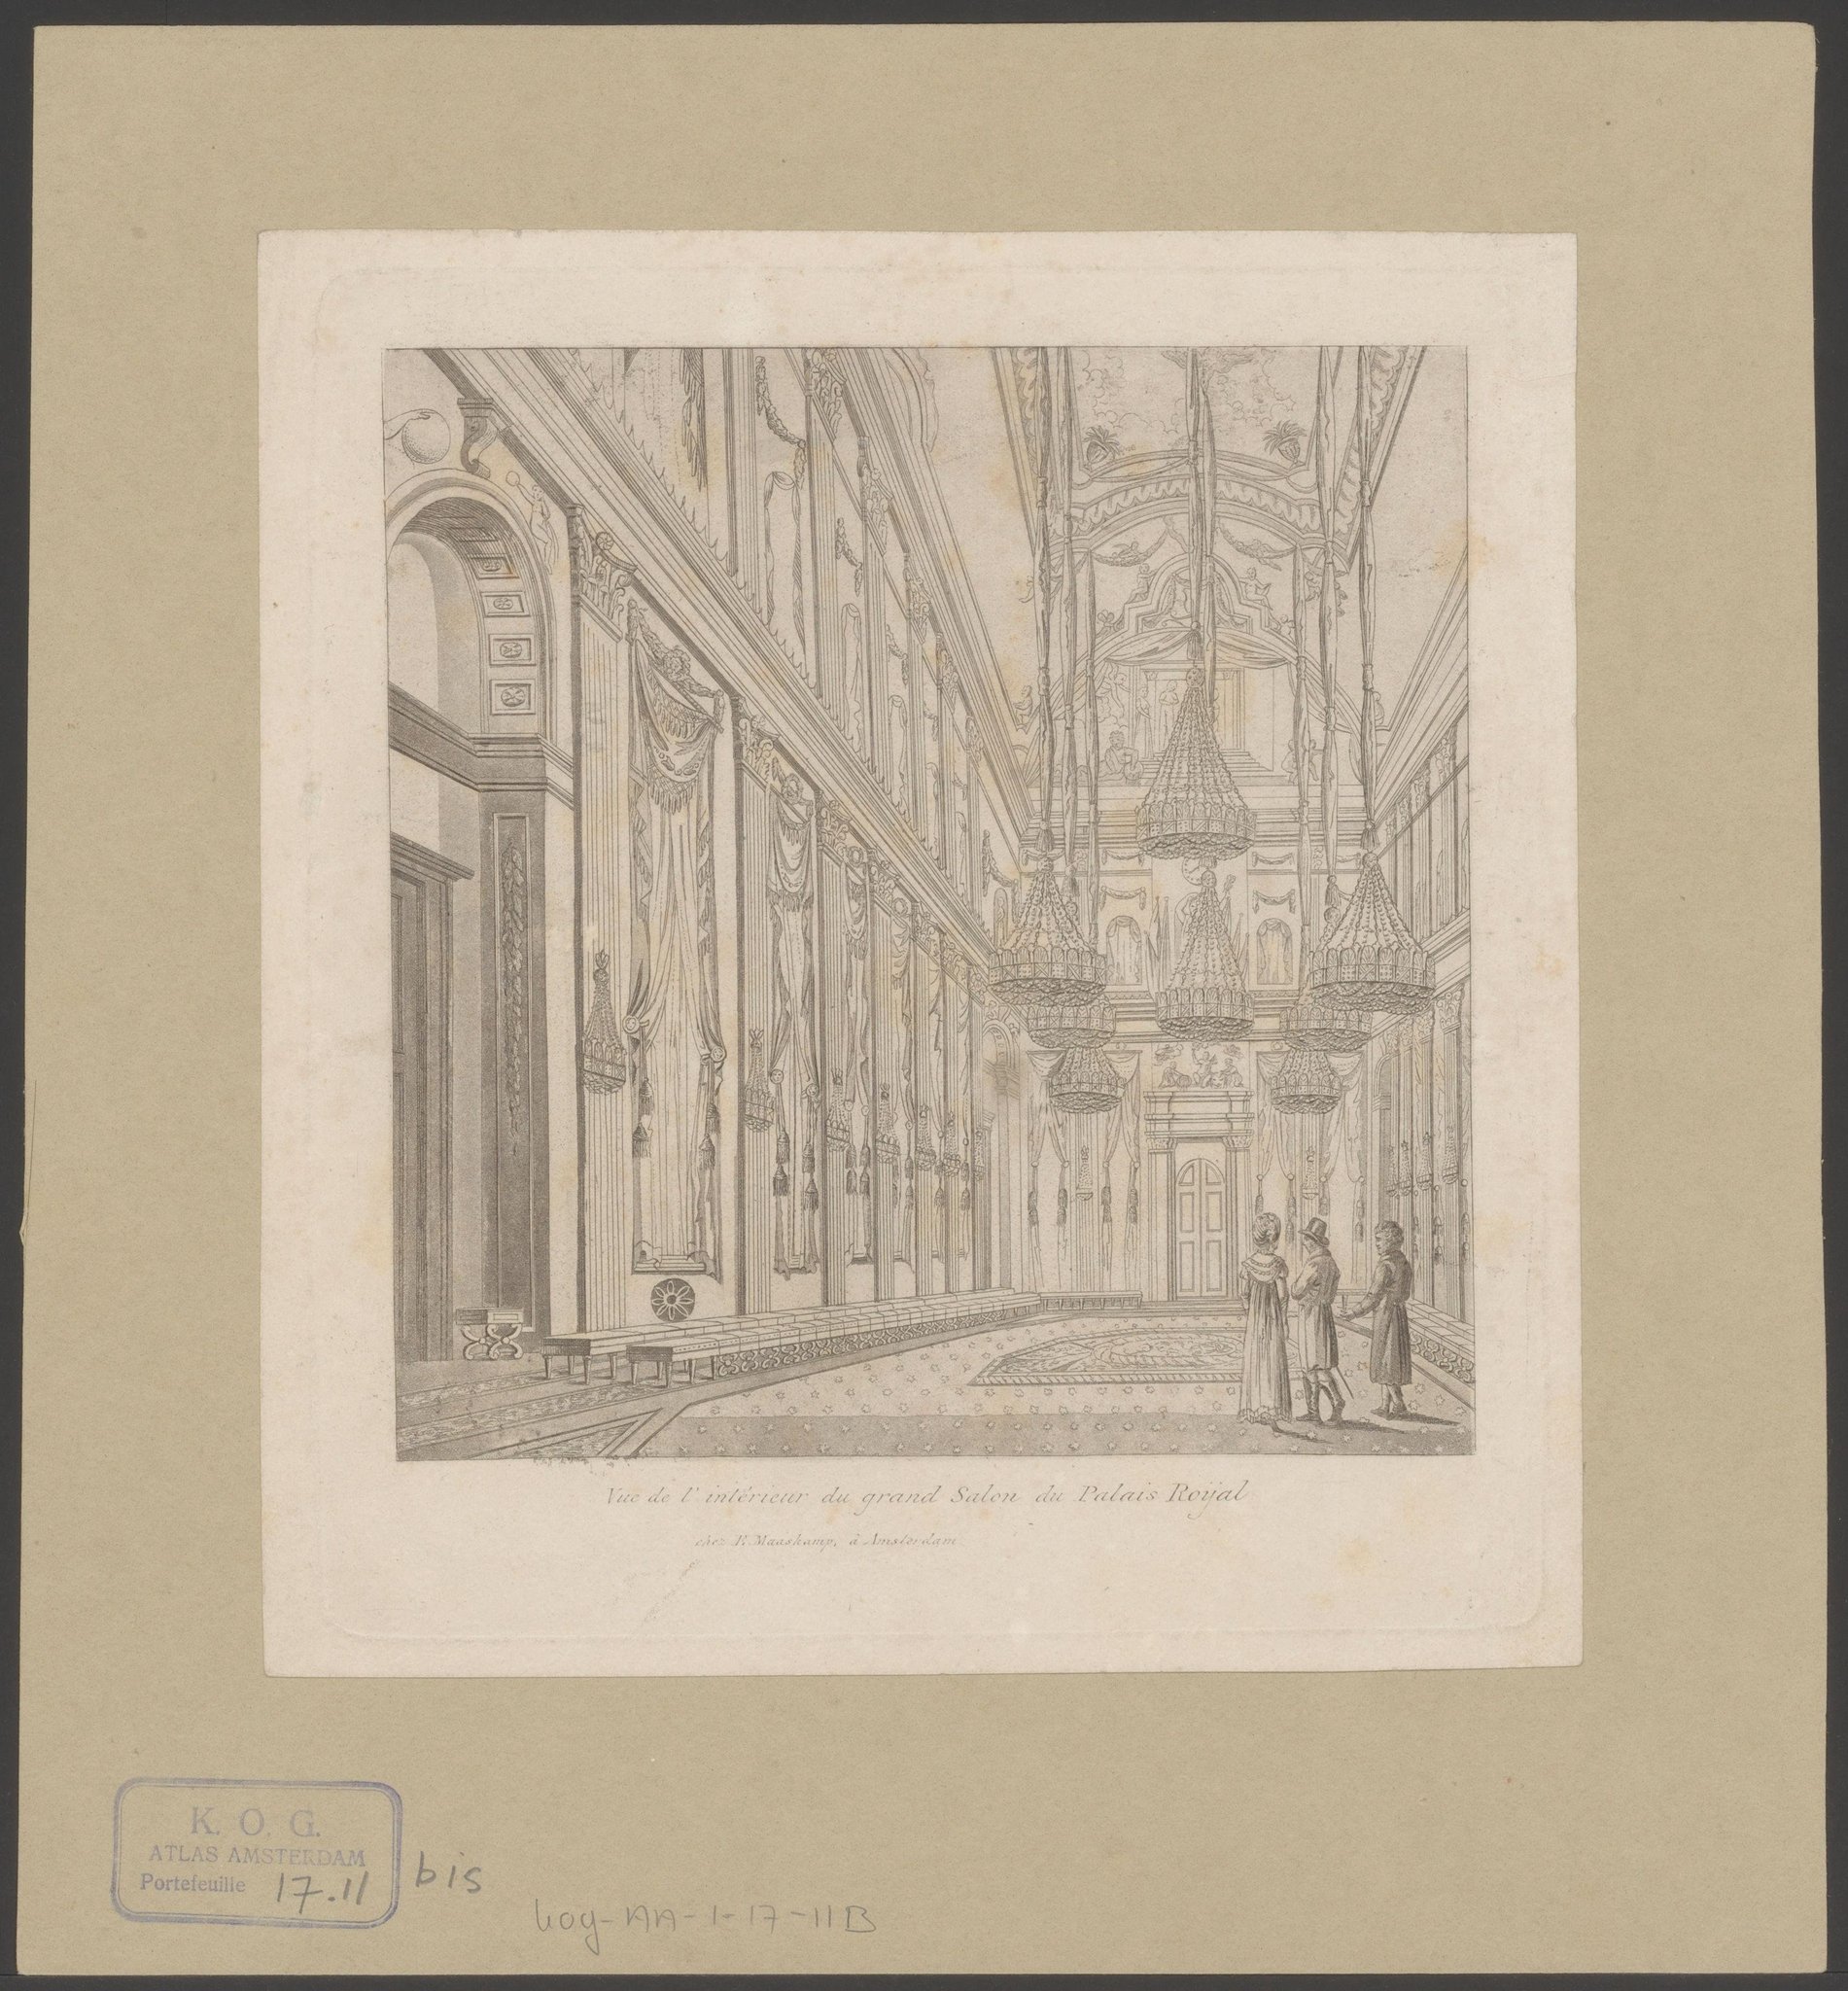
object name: print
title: Vue de l'intérieur du grand Salon du Palais Roijal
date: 1810-1813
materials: paper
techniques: aquatint, etching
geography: amsterdam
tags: townhall, royal palace of amsterdam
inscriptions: collector's mark: ‘17.11 bis’ Lugt 1641b, inscription: ‘Auctie RWP de Vries / Mei . 81.’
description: Onderwerpsrubriek binnen de Atlas Amsterdam: Nieuwe Stadhuis, van binnen: Groote zaal, Raadkamer, Schepenkamer, Troonzaal, Mozeszaal, Zitkamer.